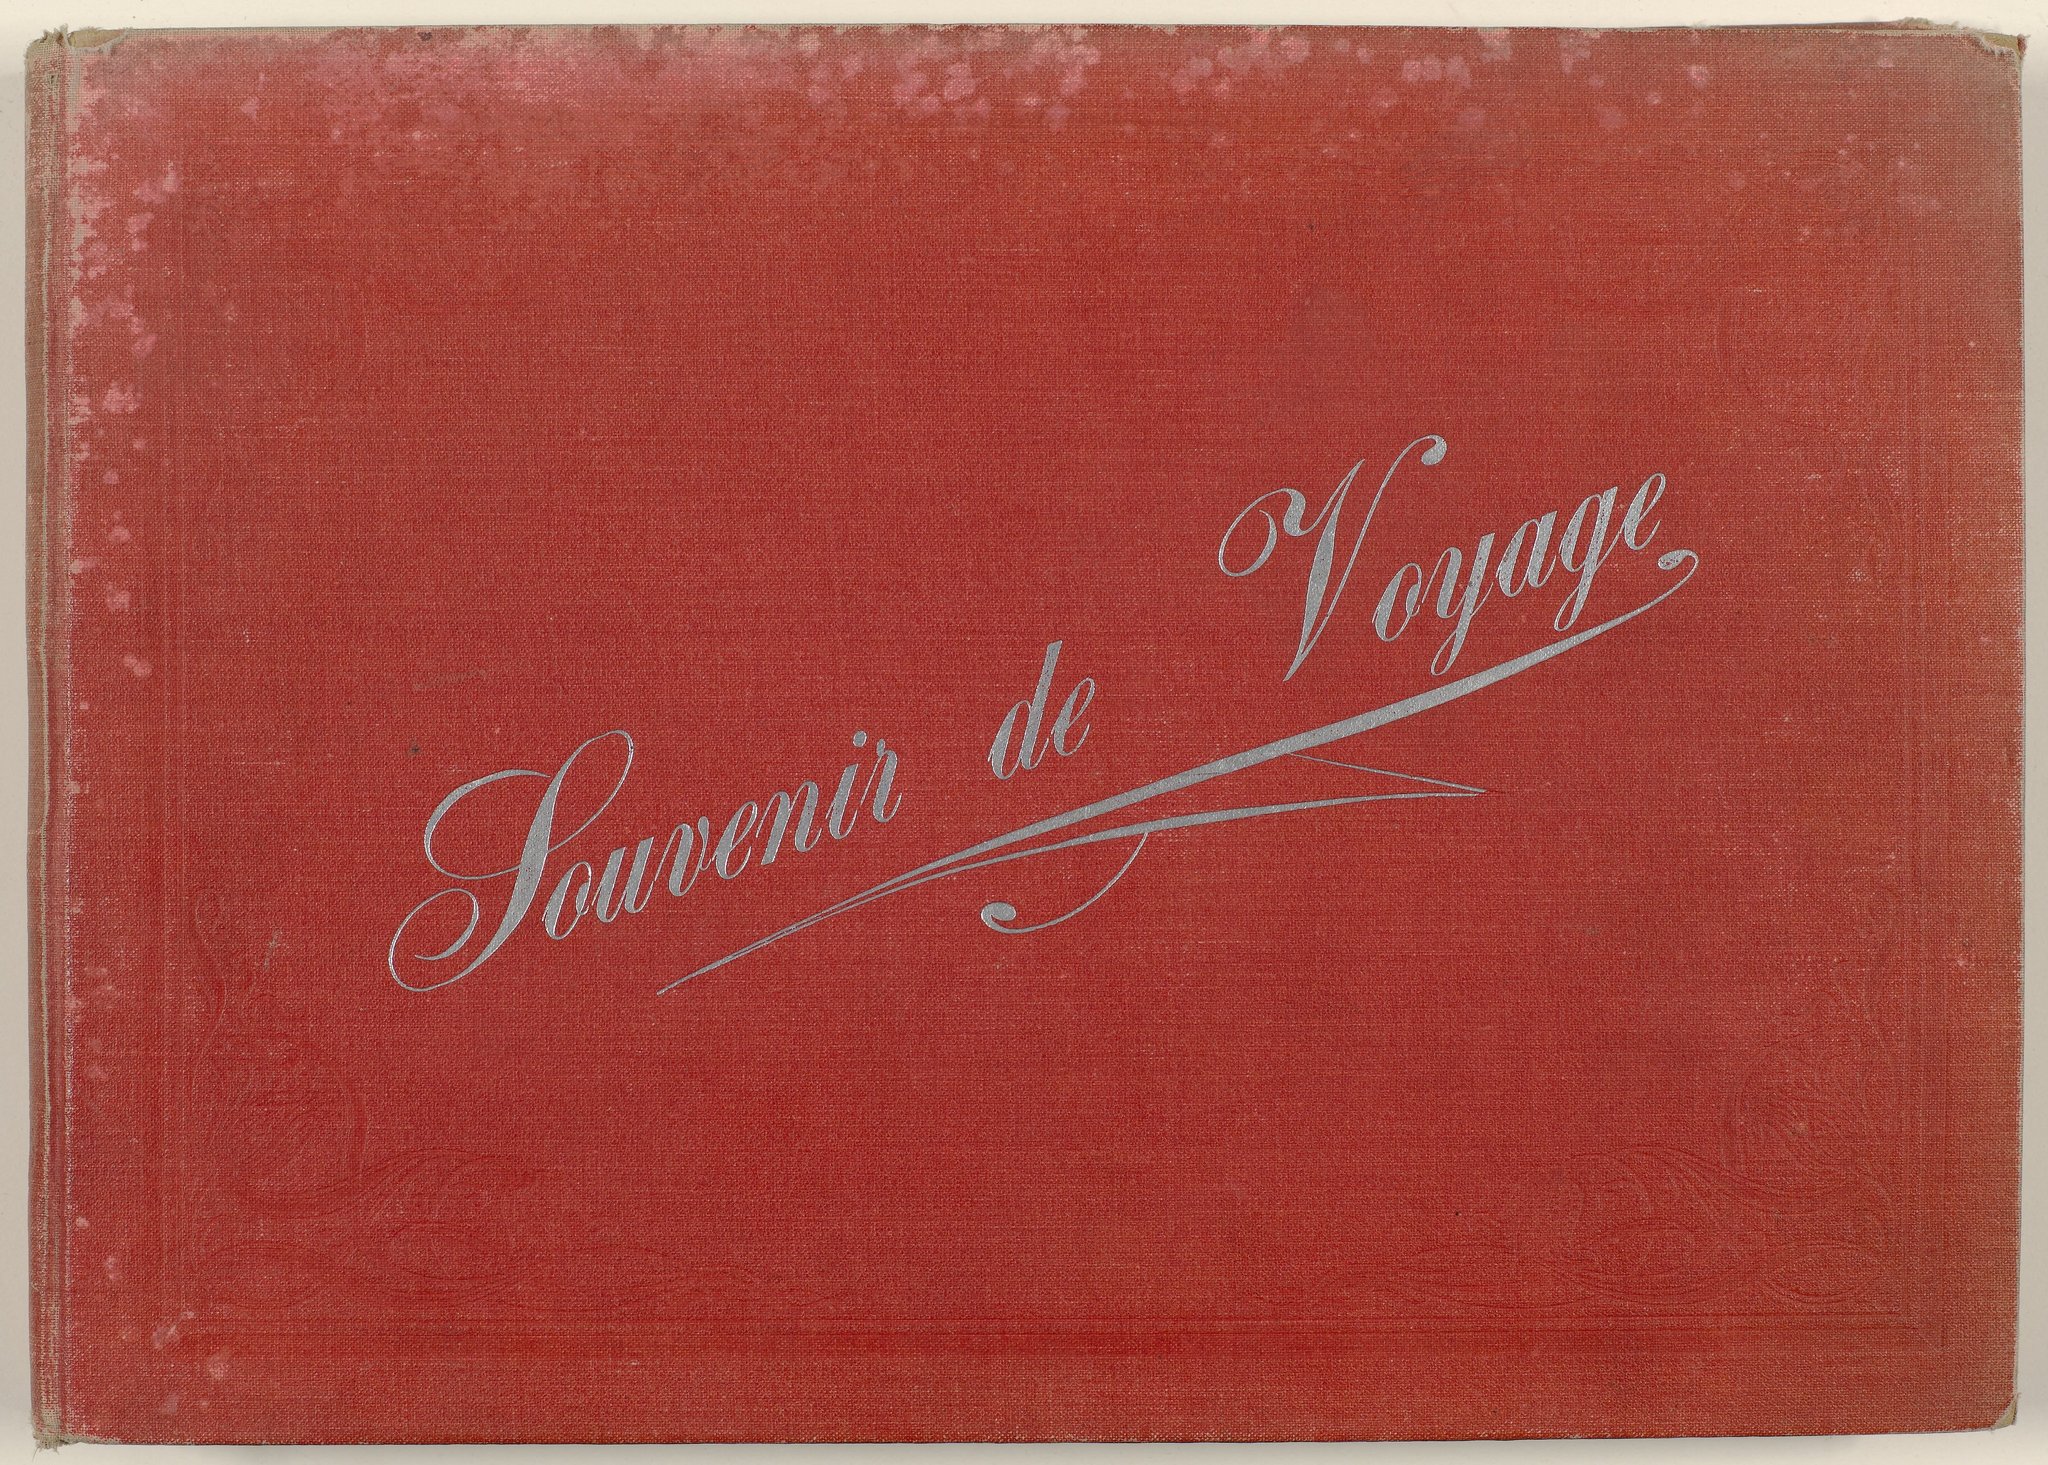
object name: photograph album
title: ‘Passengers, sleeping on the deck of a boat of K.V.’ (Koloniale Vaartuigen)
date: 1903-1910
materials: cardboard, photographic support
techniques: cyanotype, gelatin silver print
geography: suriname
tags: suriname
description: Many women coming to Suriname from India travel alone or with their children. The bottom photograph shows a group of indentured labourers asleep on a ship’s deck. The woman in the front left keeps a watchful eye on the photographer. She wears bangles (Indian bracelets) and leans on a gathri, a cotton bundle of belongings. The distinctive box in the middle probably contains the group’s valuables.